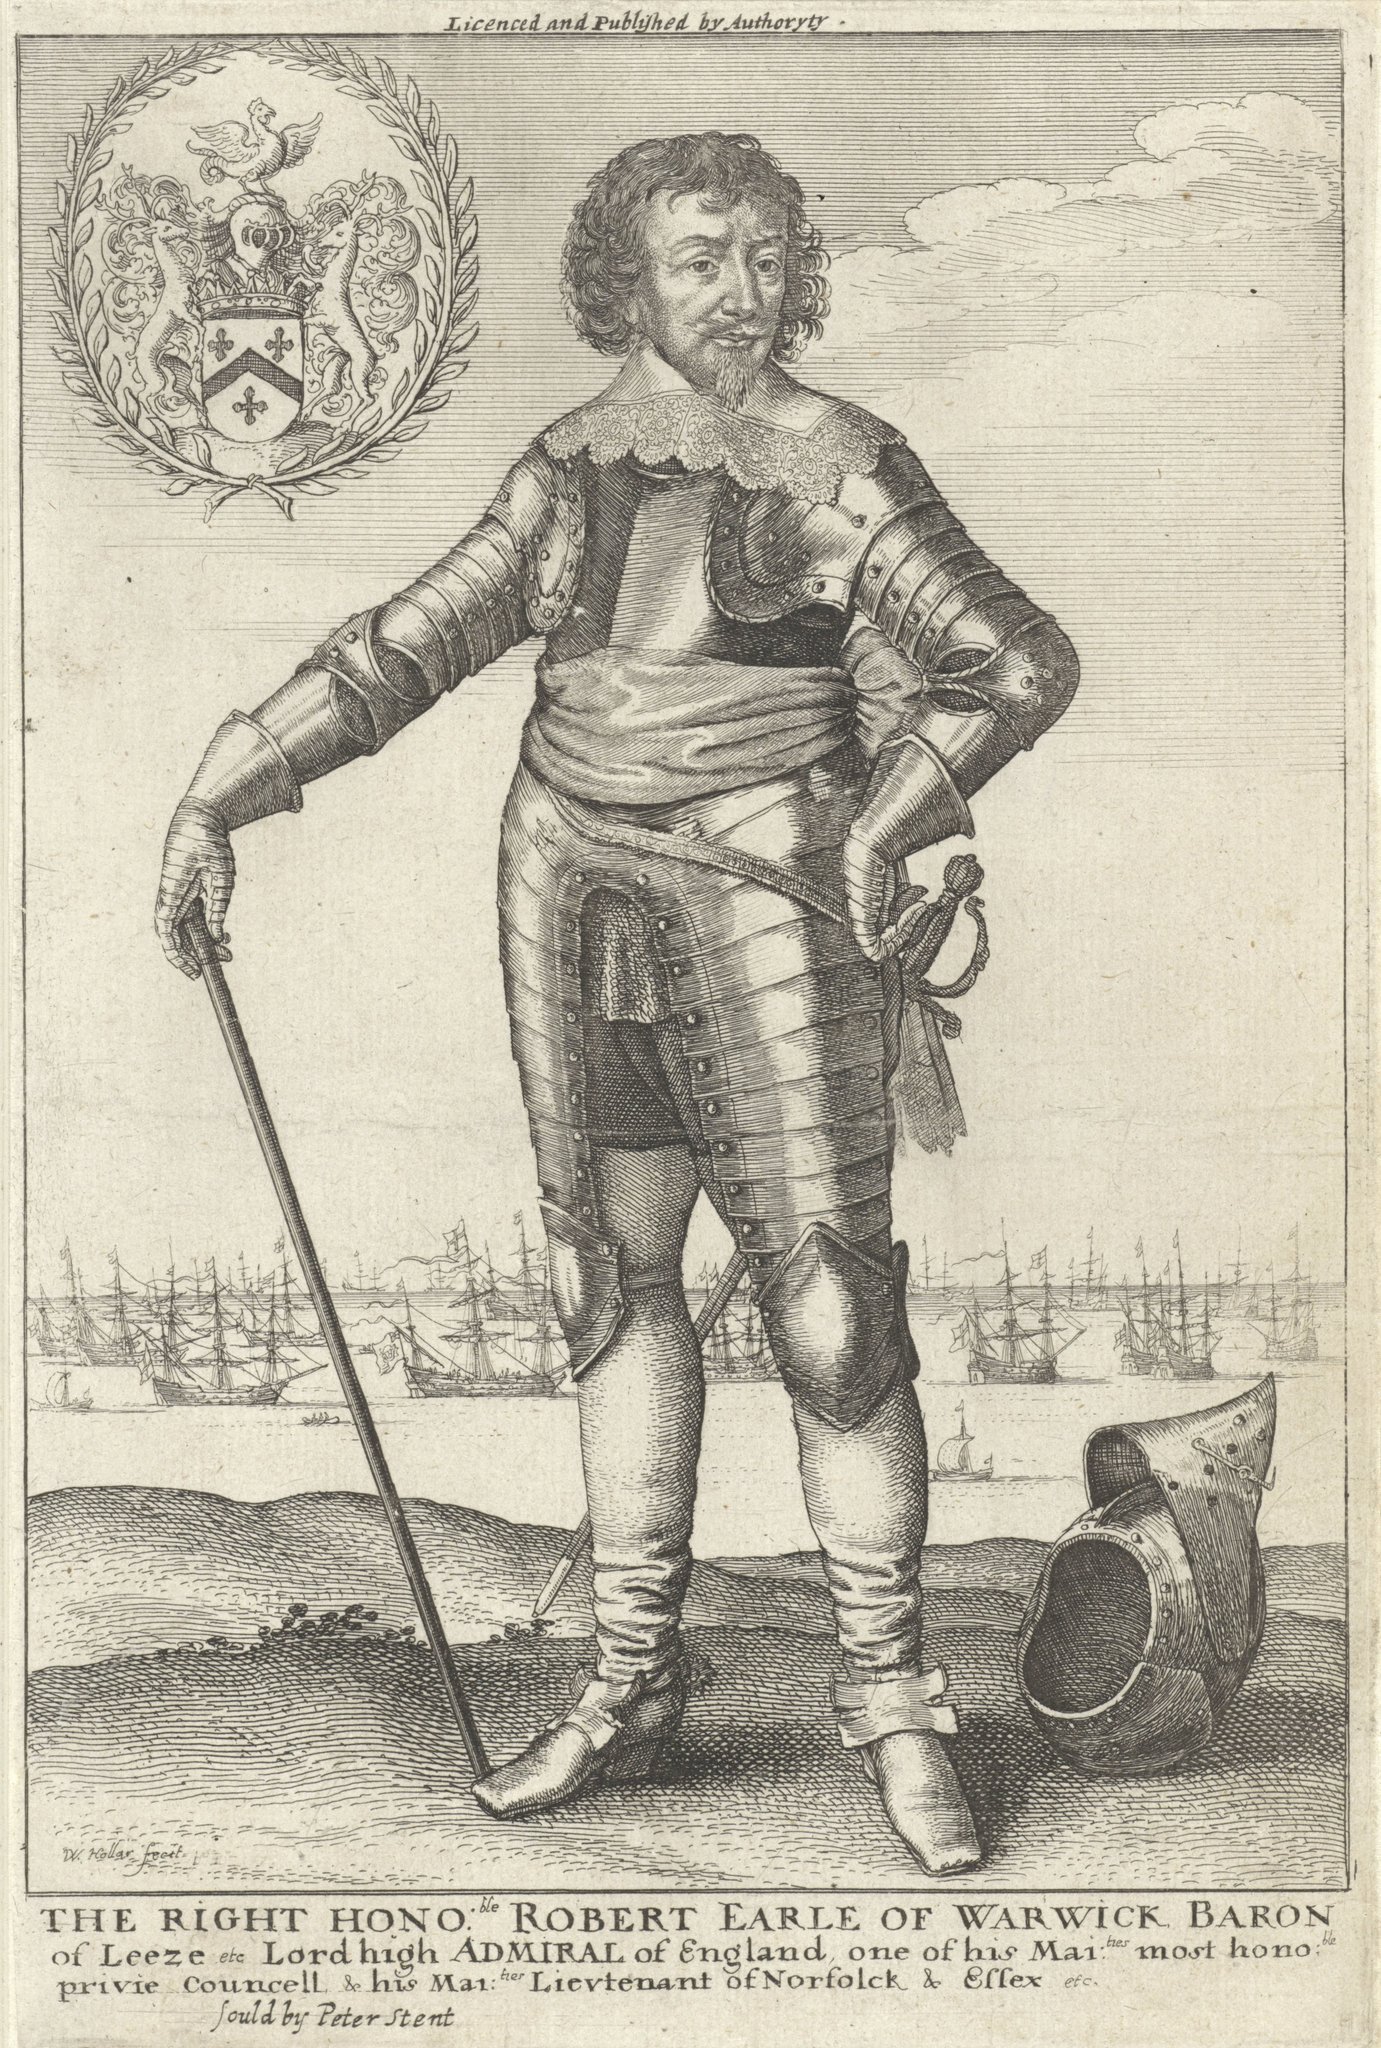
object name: print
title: Portret van Robert Rich, graaf van Warwick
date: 1642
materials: paper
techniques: etching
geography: london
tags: armour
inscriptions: collector's mark: Lugt 2228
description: Portret van de zeeofficier Robert Rich, graaf van Warwick.